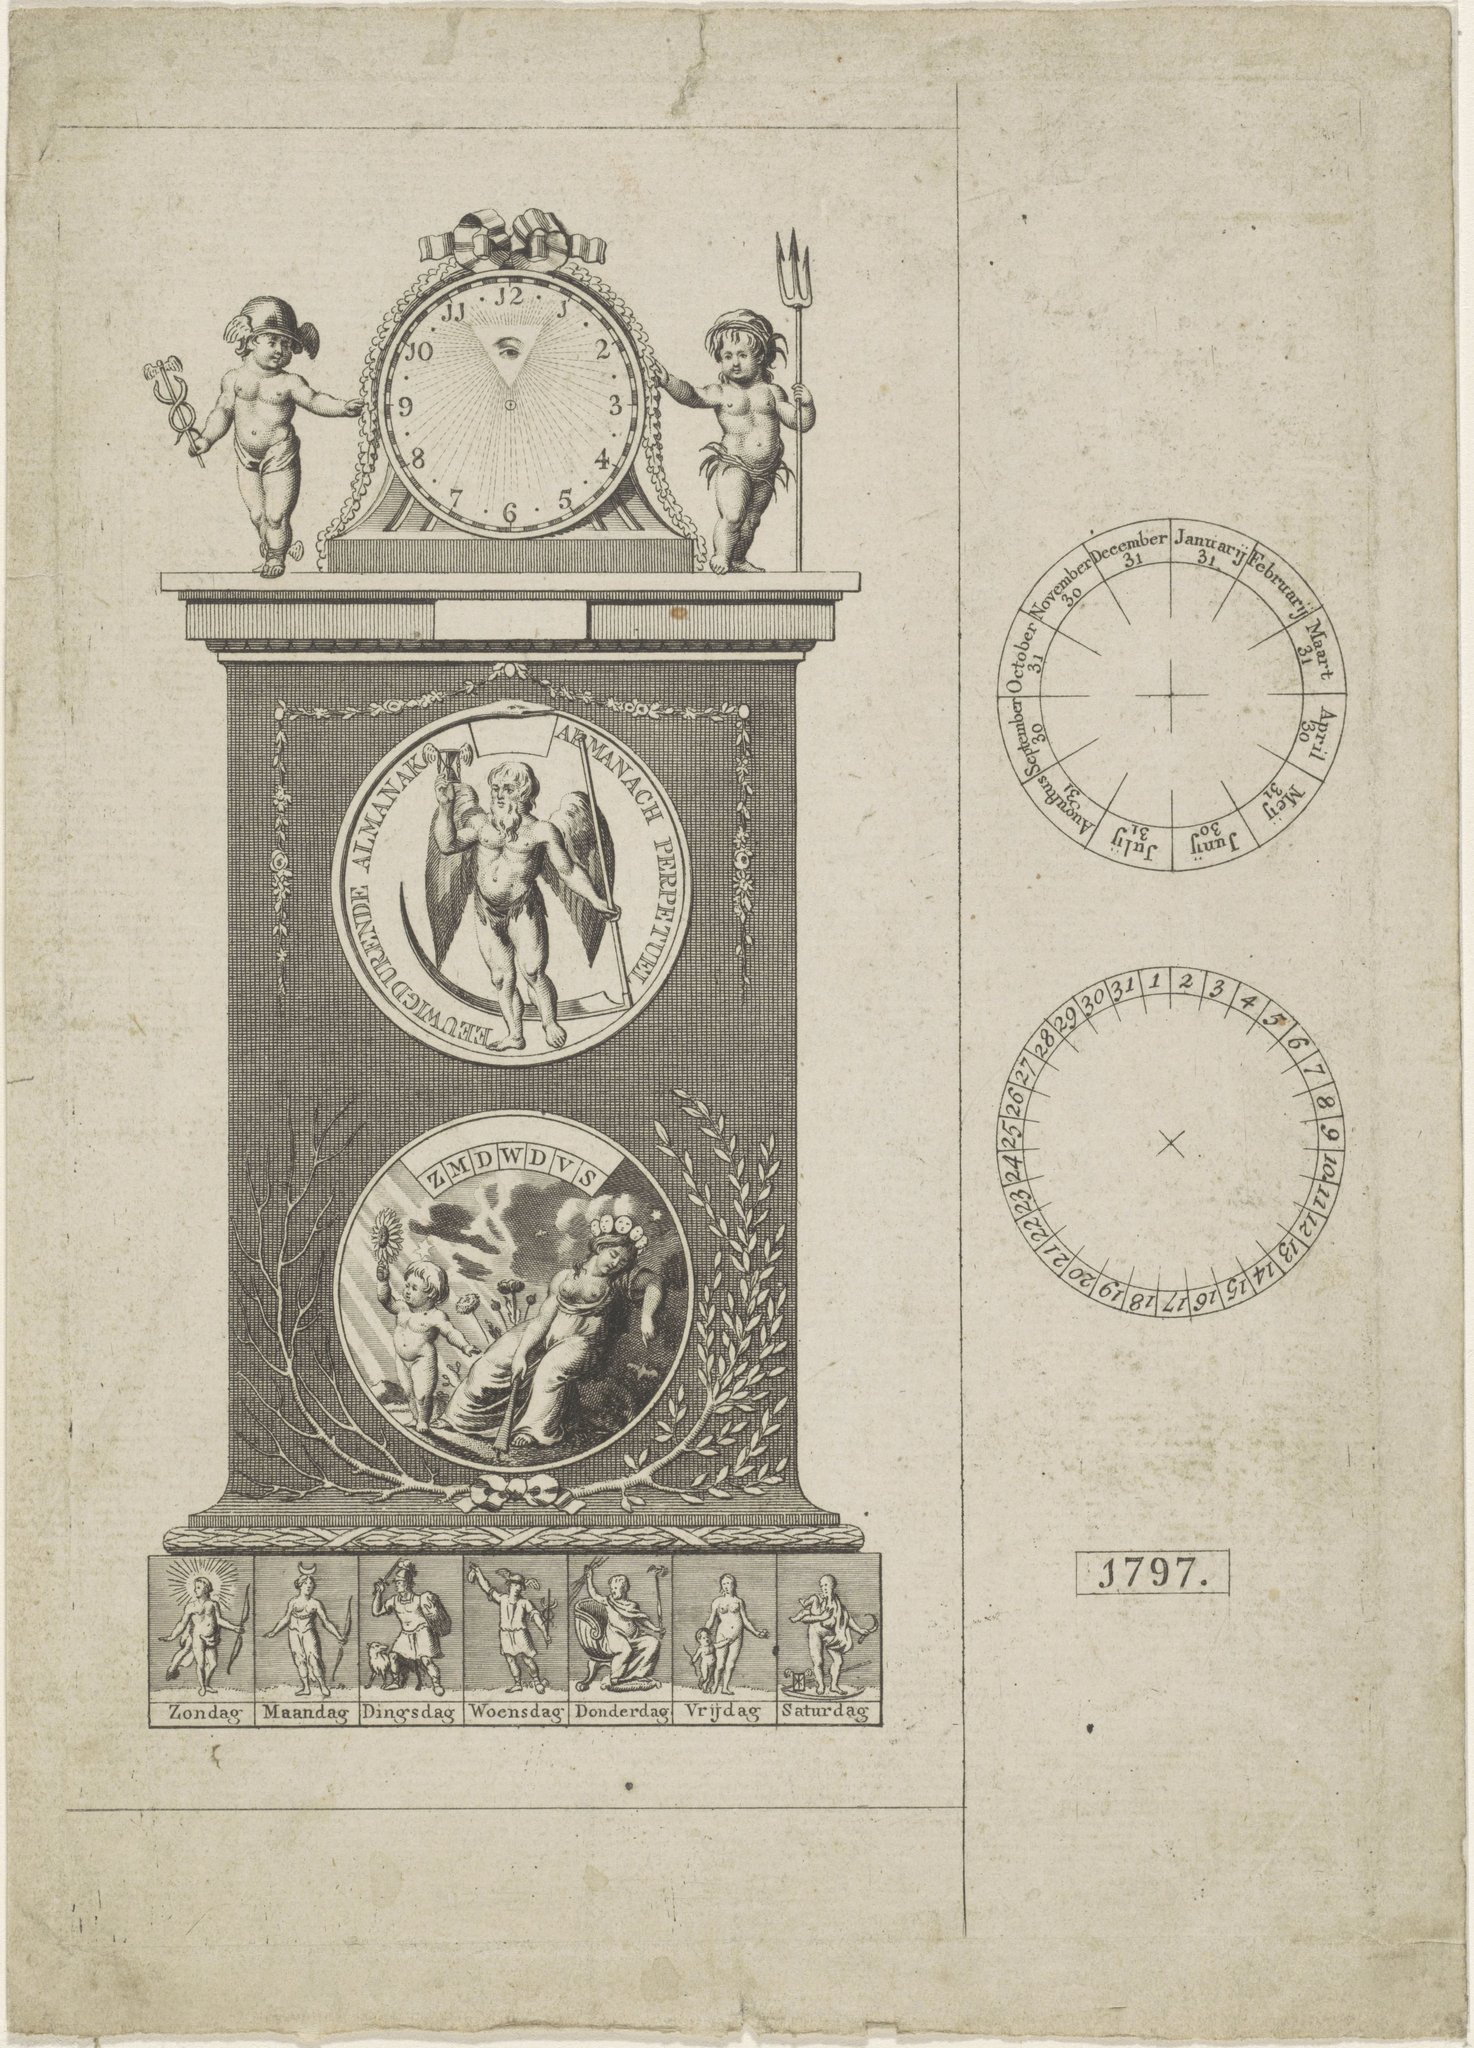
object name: ornament print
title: Ontwerp voor een klok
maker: Anonymous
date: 1797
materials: paper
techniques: etching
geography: netherlands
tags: days of the week, clock, father time, man with wings and scythe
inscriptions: collector's mark: Lugt 2228, collector's mark: Lugt 2760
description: Ontwerp voor een 'eeuwigdurende' klok. Geheel boven de klok met aan weerszijden putti: de een met de attributen van Mercurius, de ander met de attributen van Neptunus. In medaillons een voorstelling van Vader Tijd en van de Dag met zonnebloem en de slapende Nacht. Onderaan op het basement de dagen van de week.